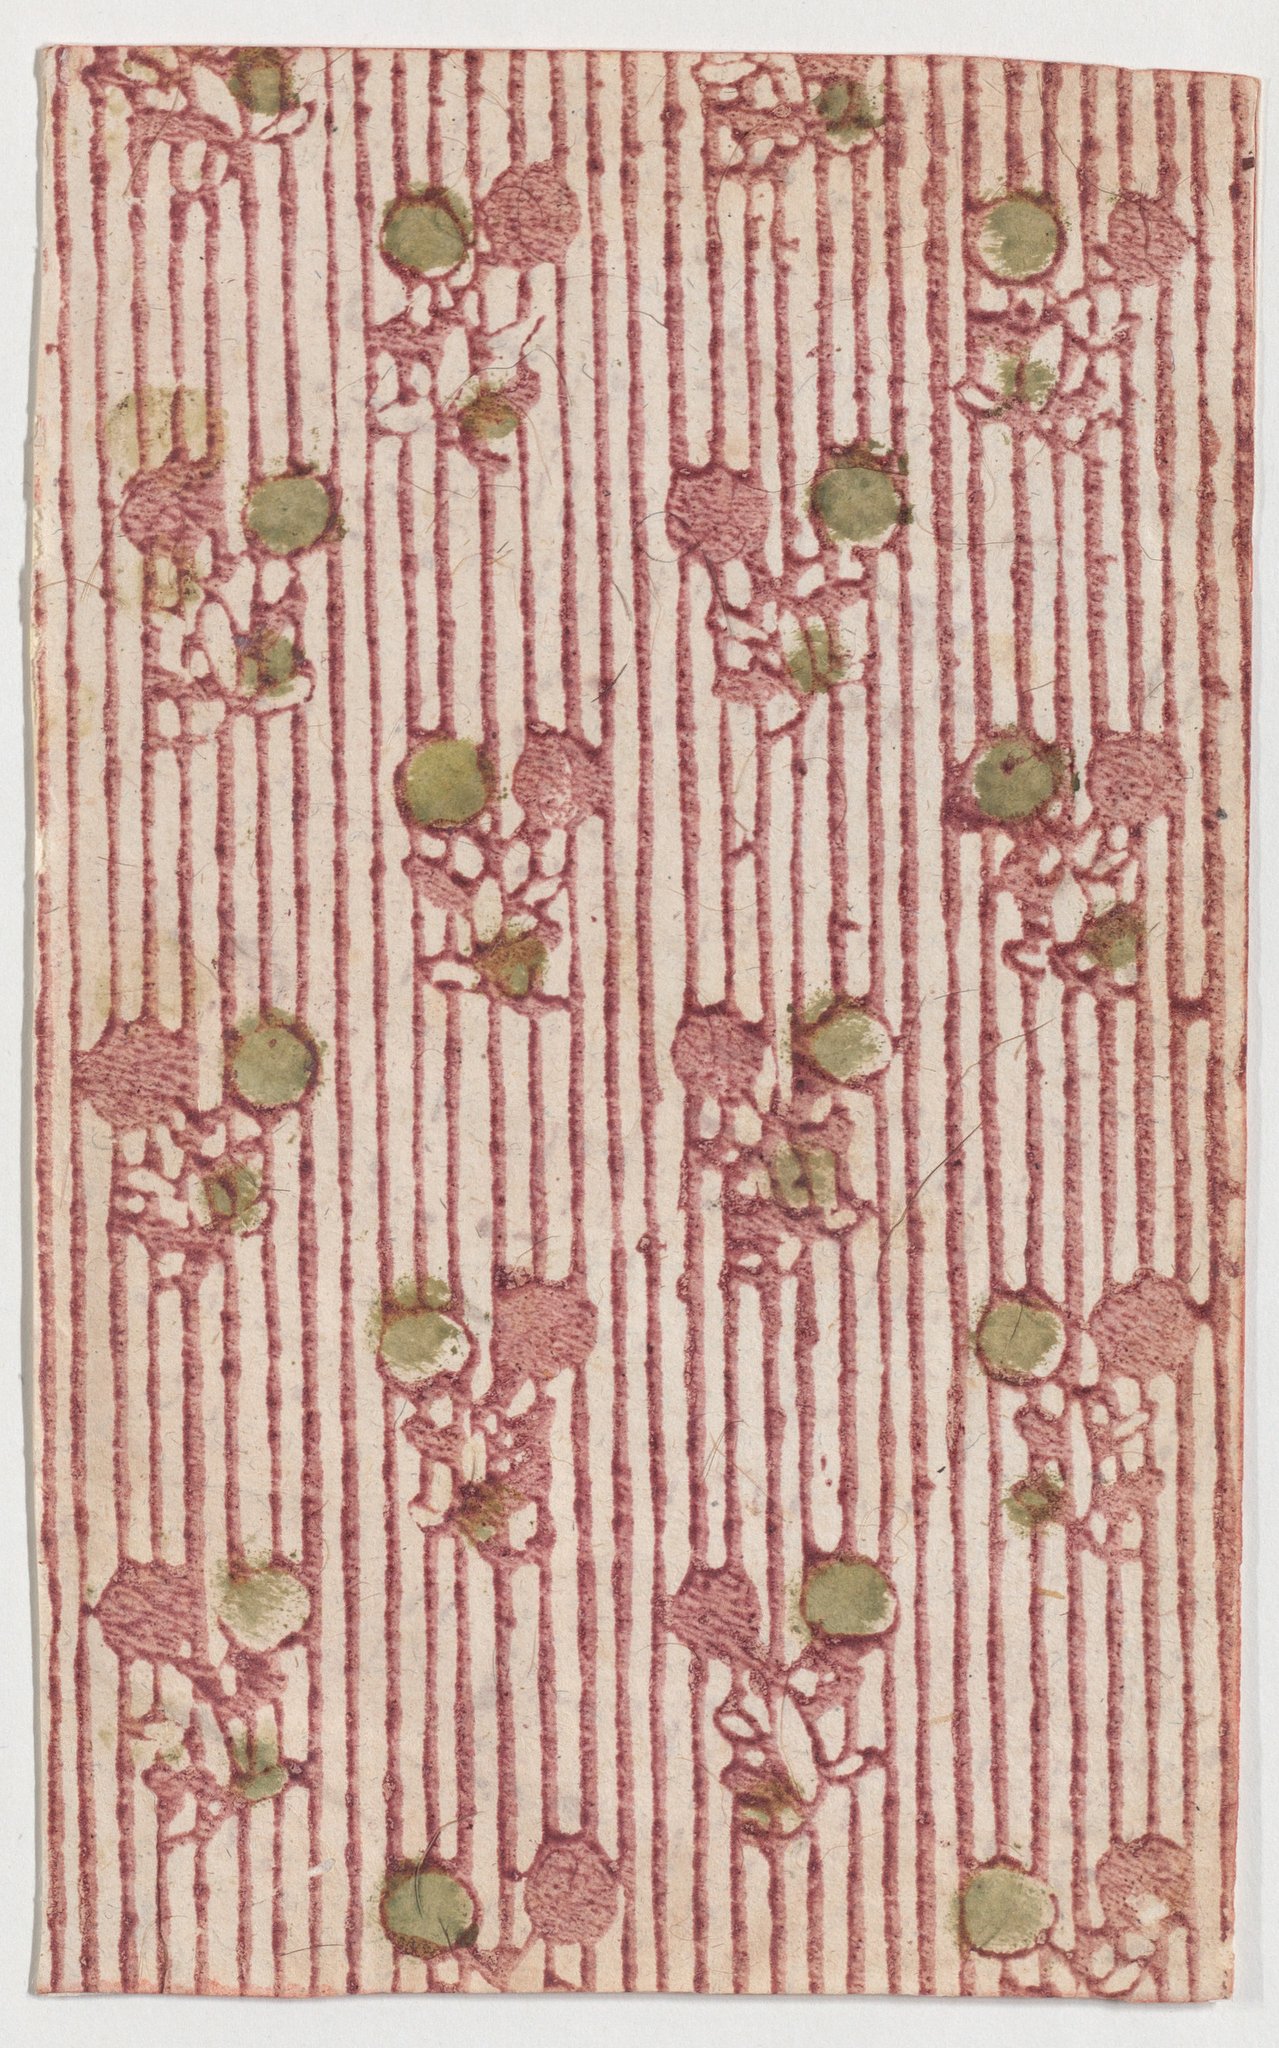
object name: print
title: Sheet with overall striped pattern with circles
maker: Anonymous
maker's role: artist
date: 1801-1900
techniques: relief print